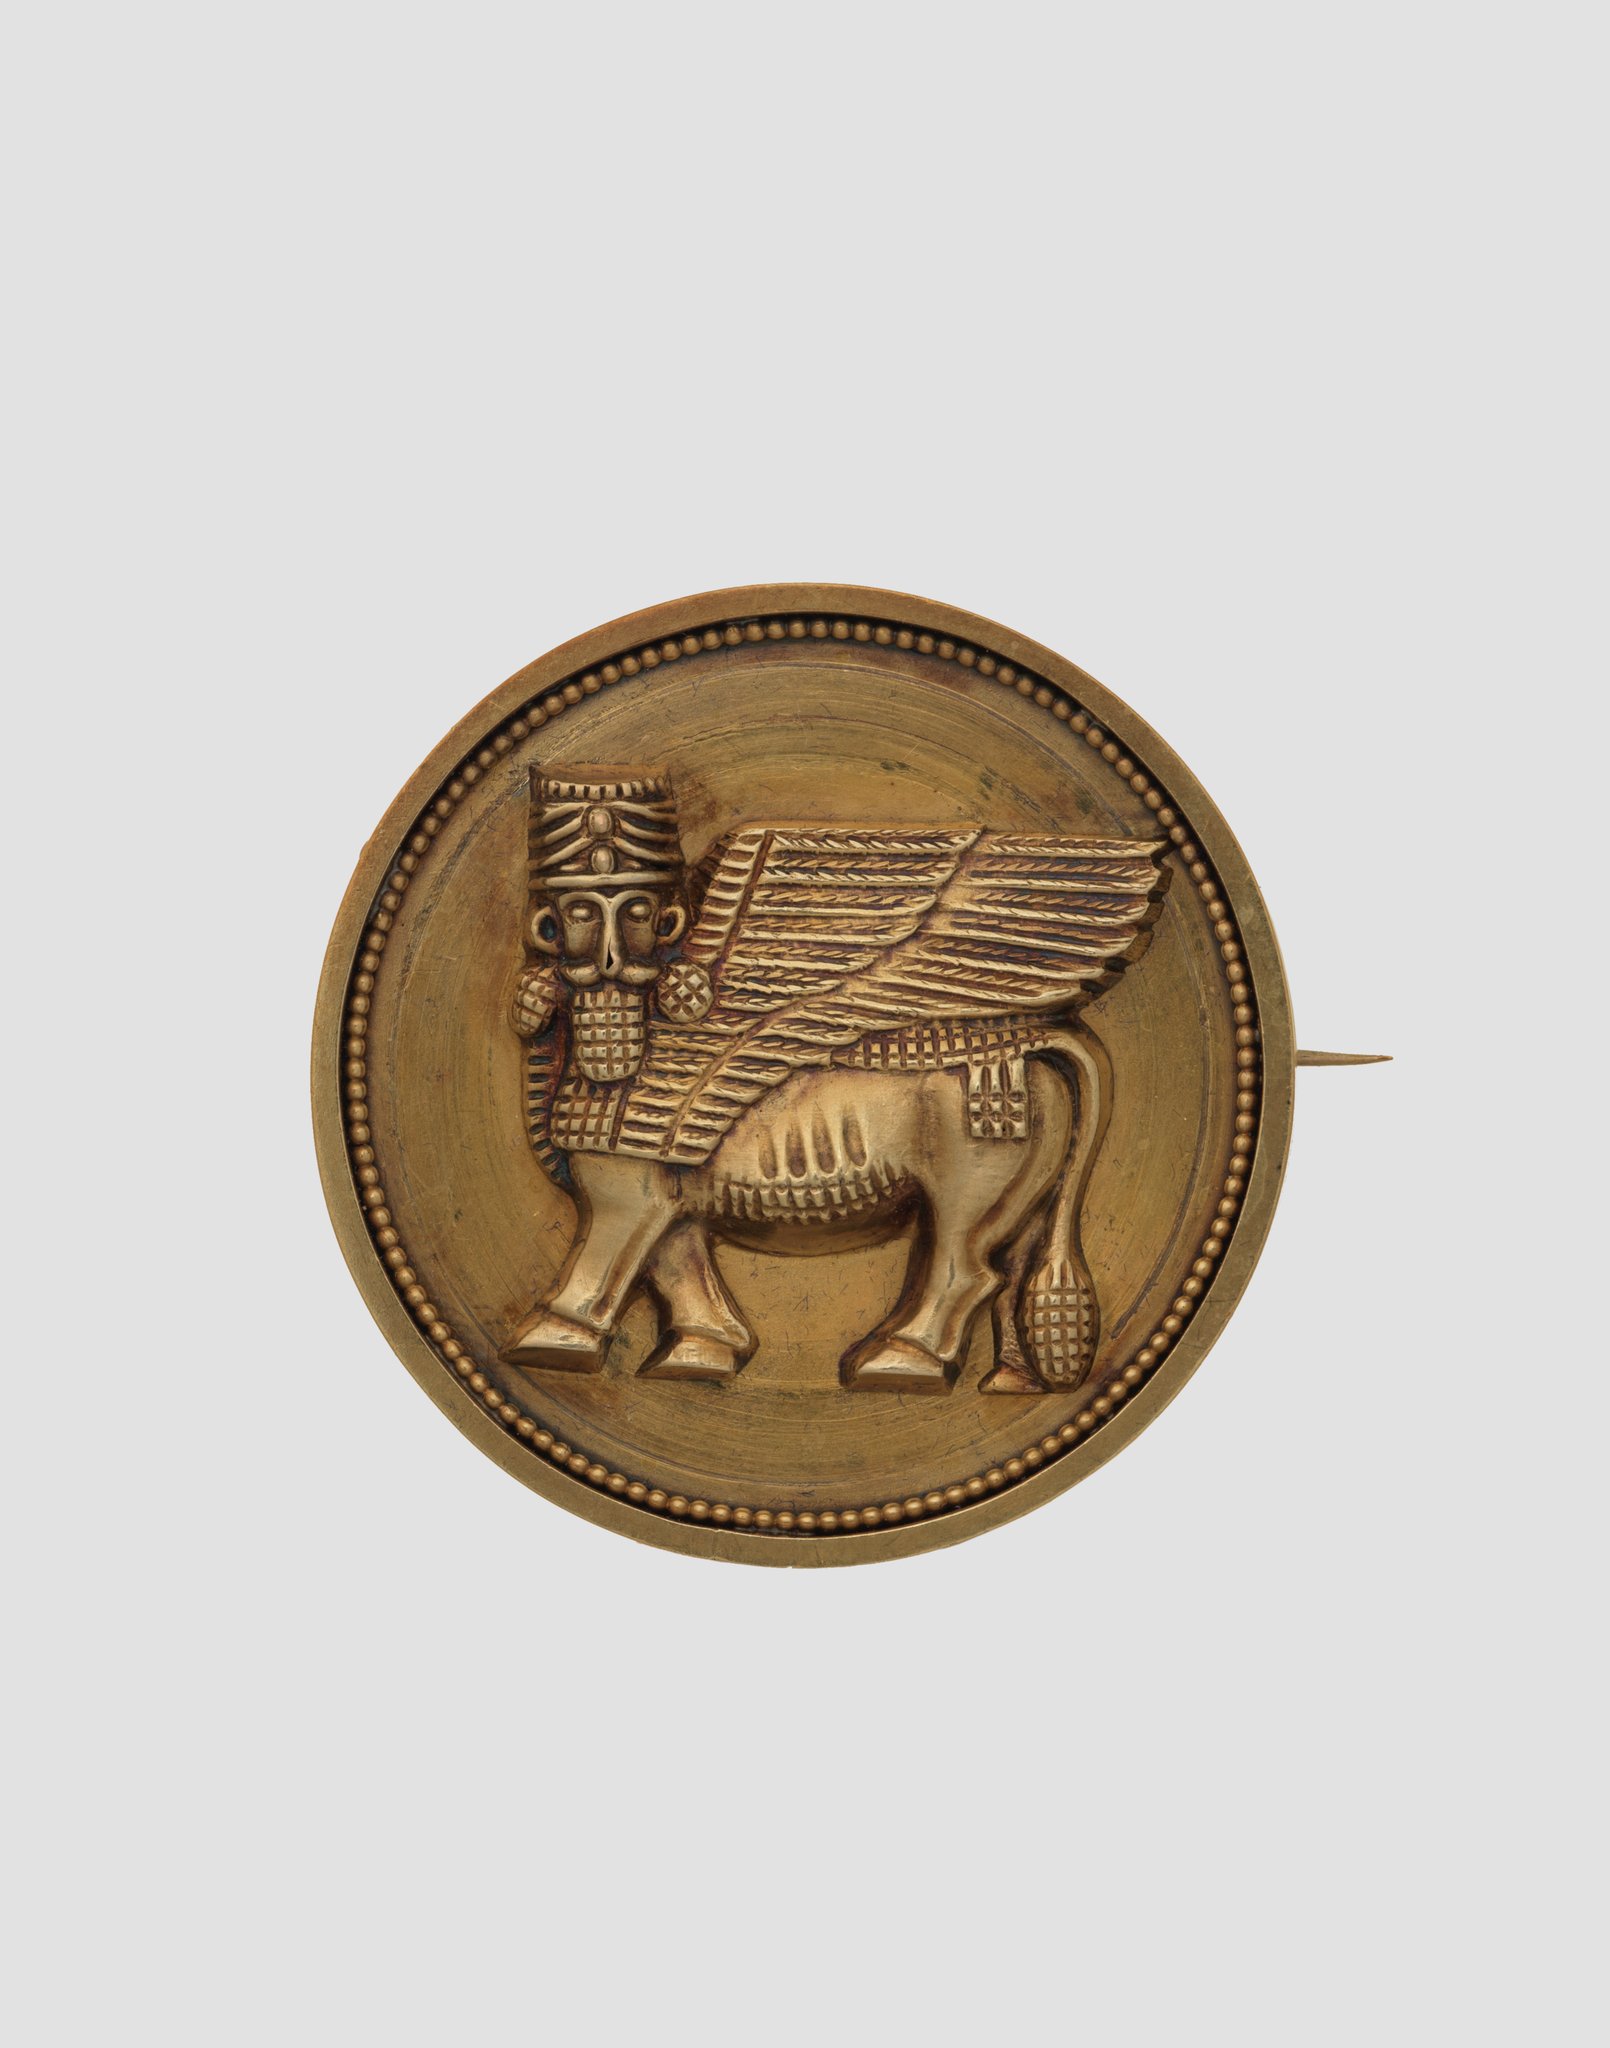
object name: brooch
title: Brooch with Assyrian winged human-headed bull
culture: british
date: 1870-1875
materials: glass, gold